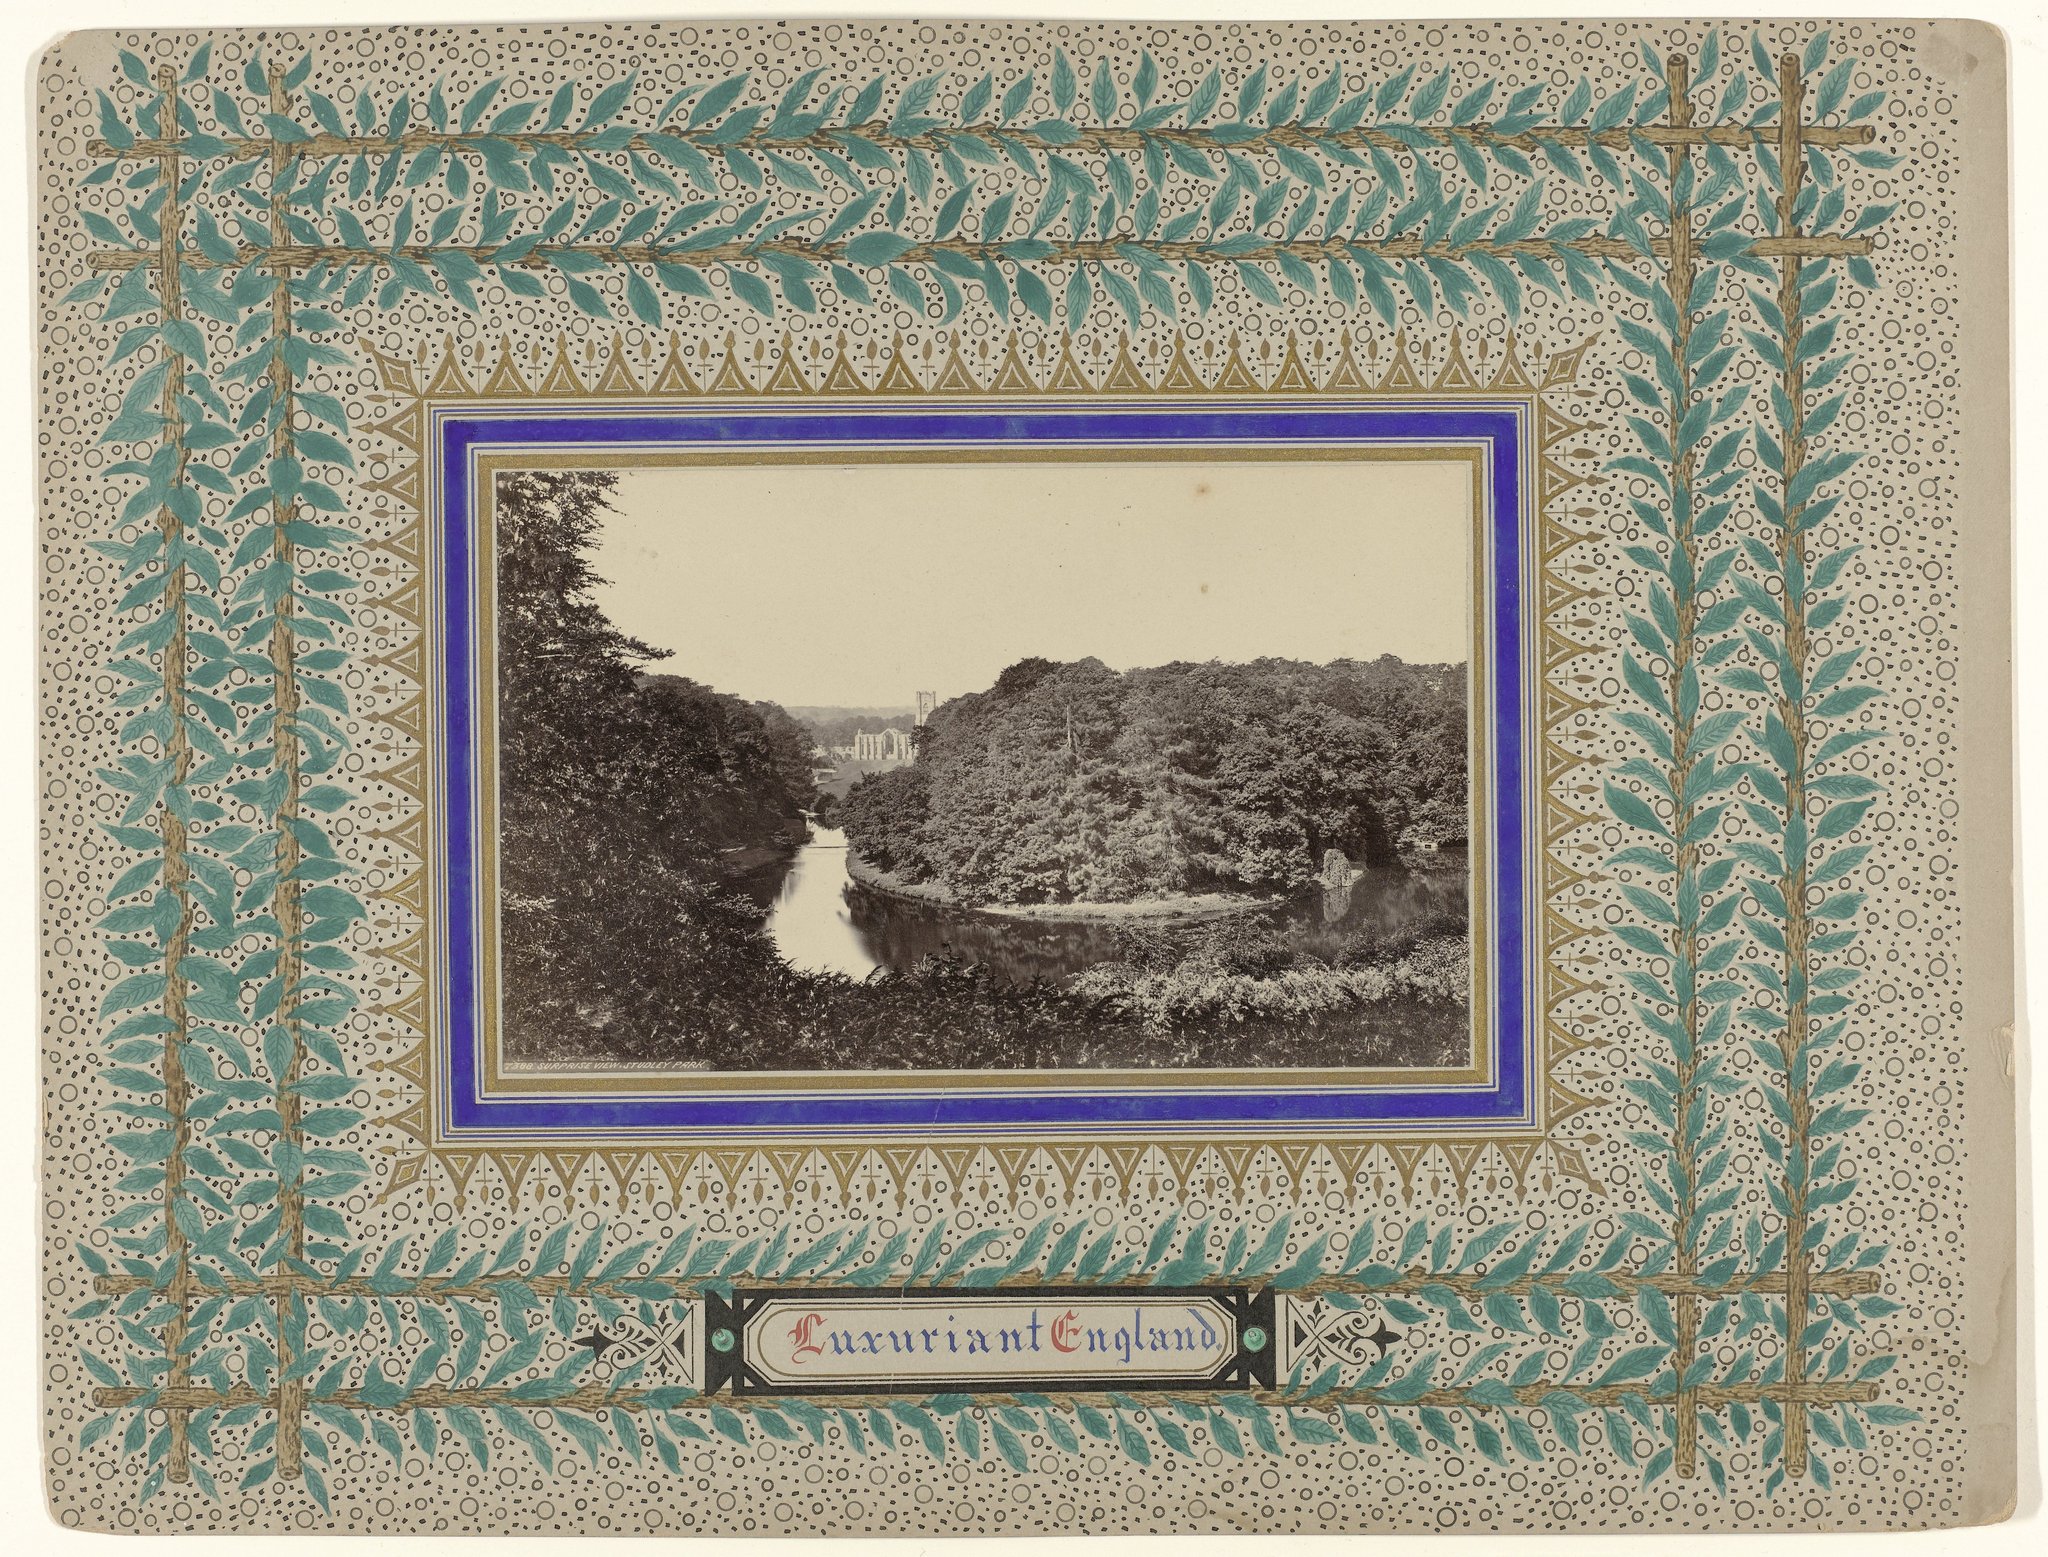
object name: photograph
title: Luxuriant England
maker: Anonymous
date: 1870-1880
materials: cardboard, paper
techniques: albumen print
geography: studley royal park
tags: landscape with ruins, public gardens, park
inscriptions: number: ‘7388.’